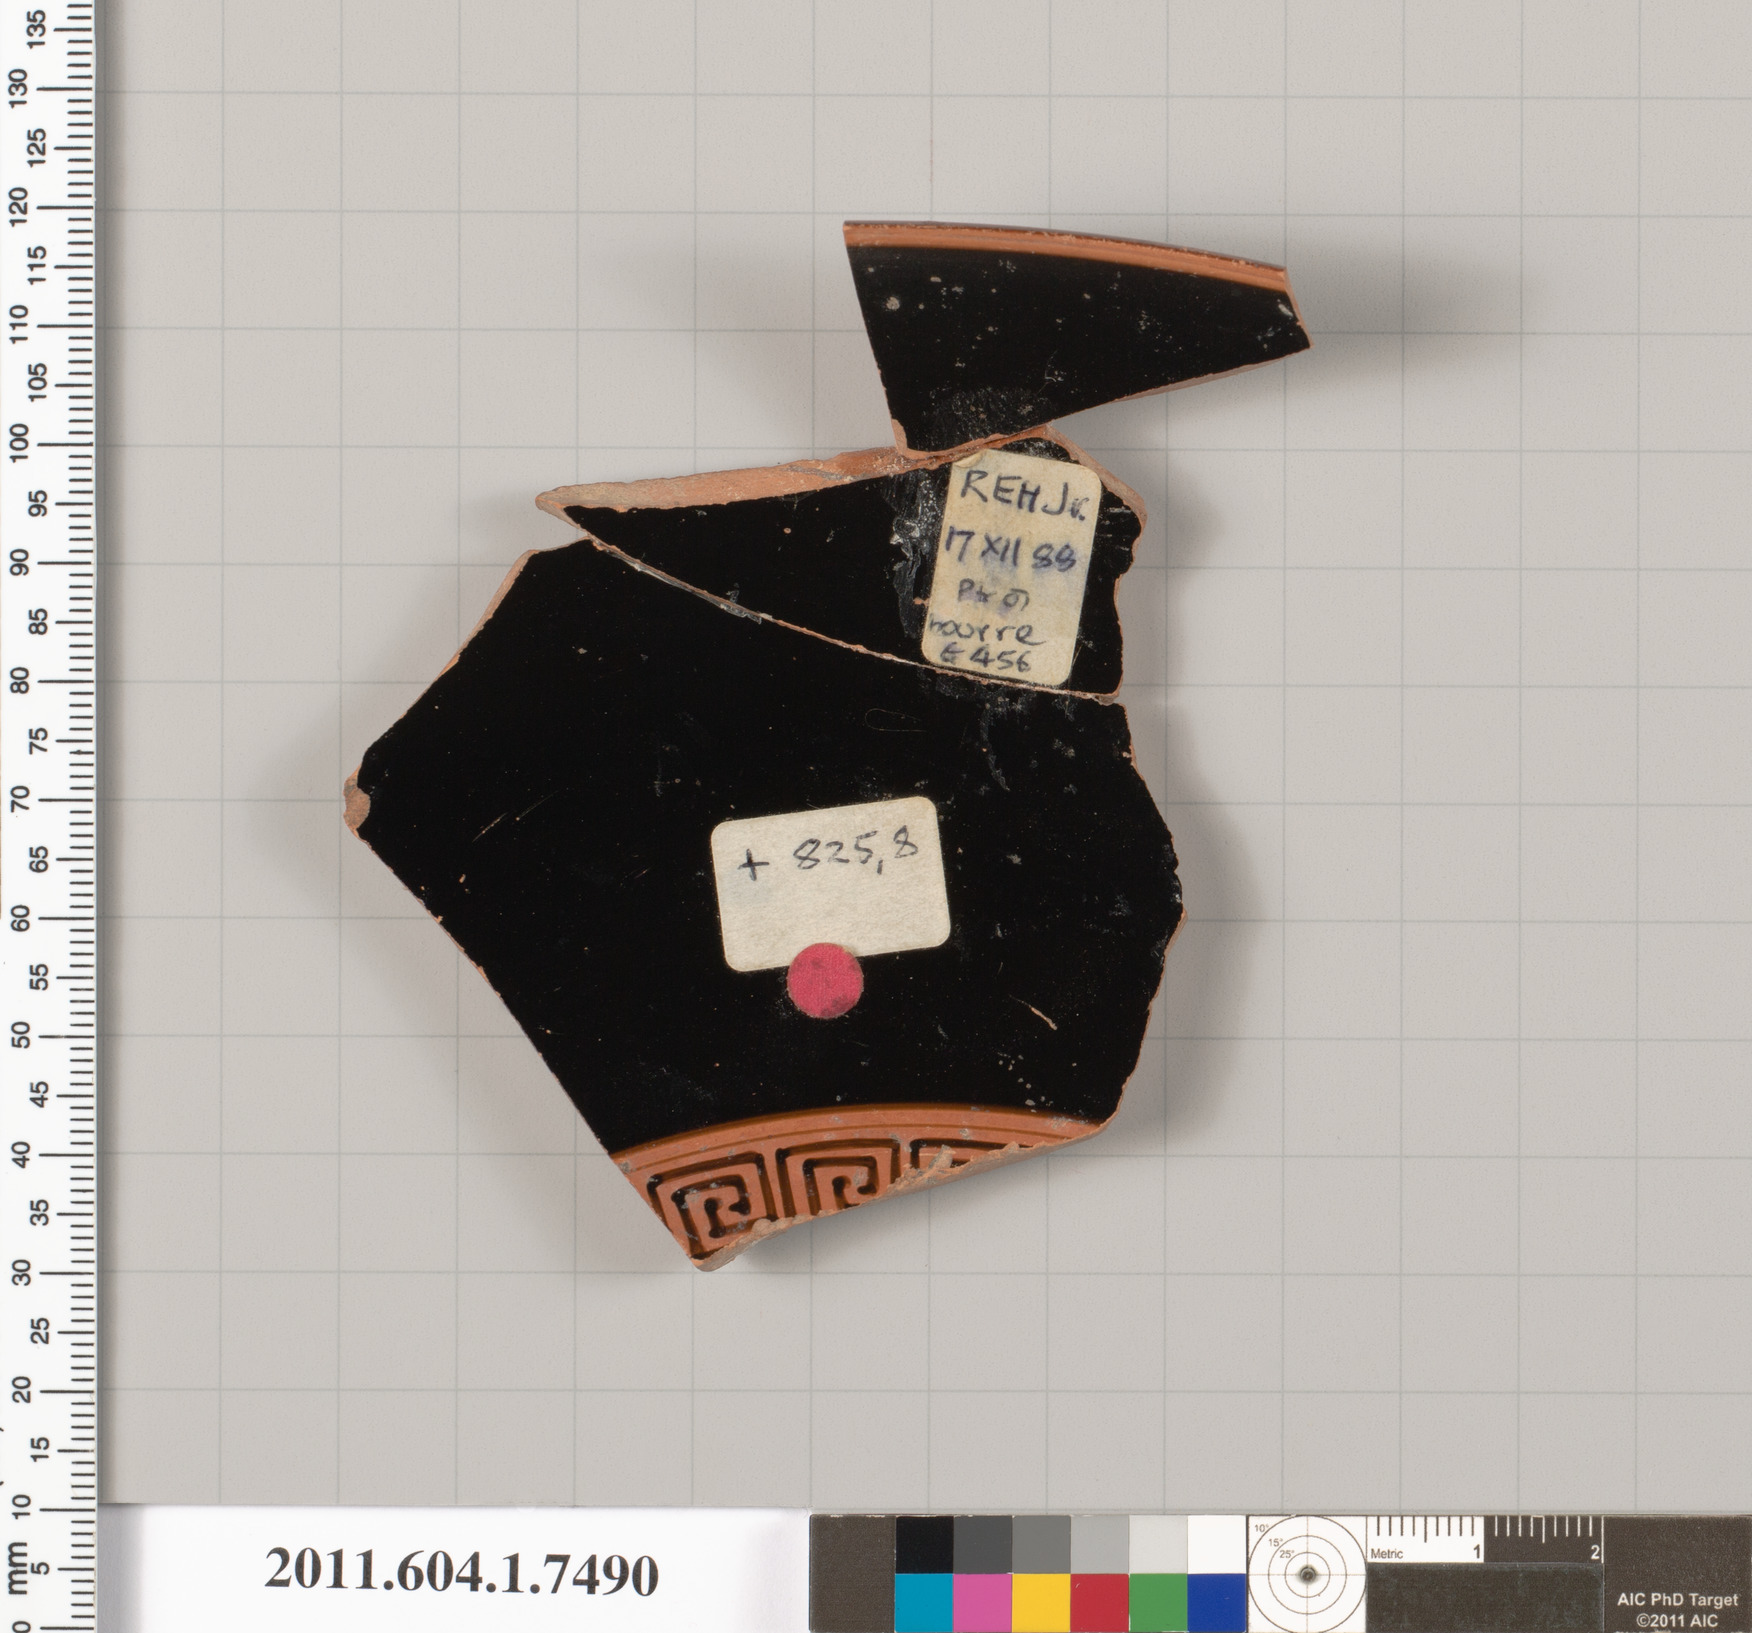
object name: kylix fragment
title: Terracotta rim fragment of a kylix (drinking cup)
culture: greek, attic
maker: painter of louvre g 456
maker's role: artist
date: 460-450 BCE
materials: terracotta